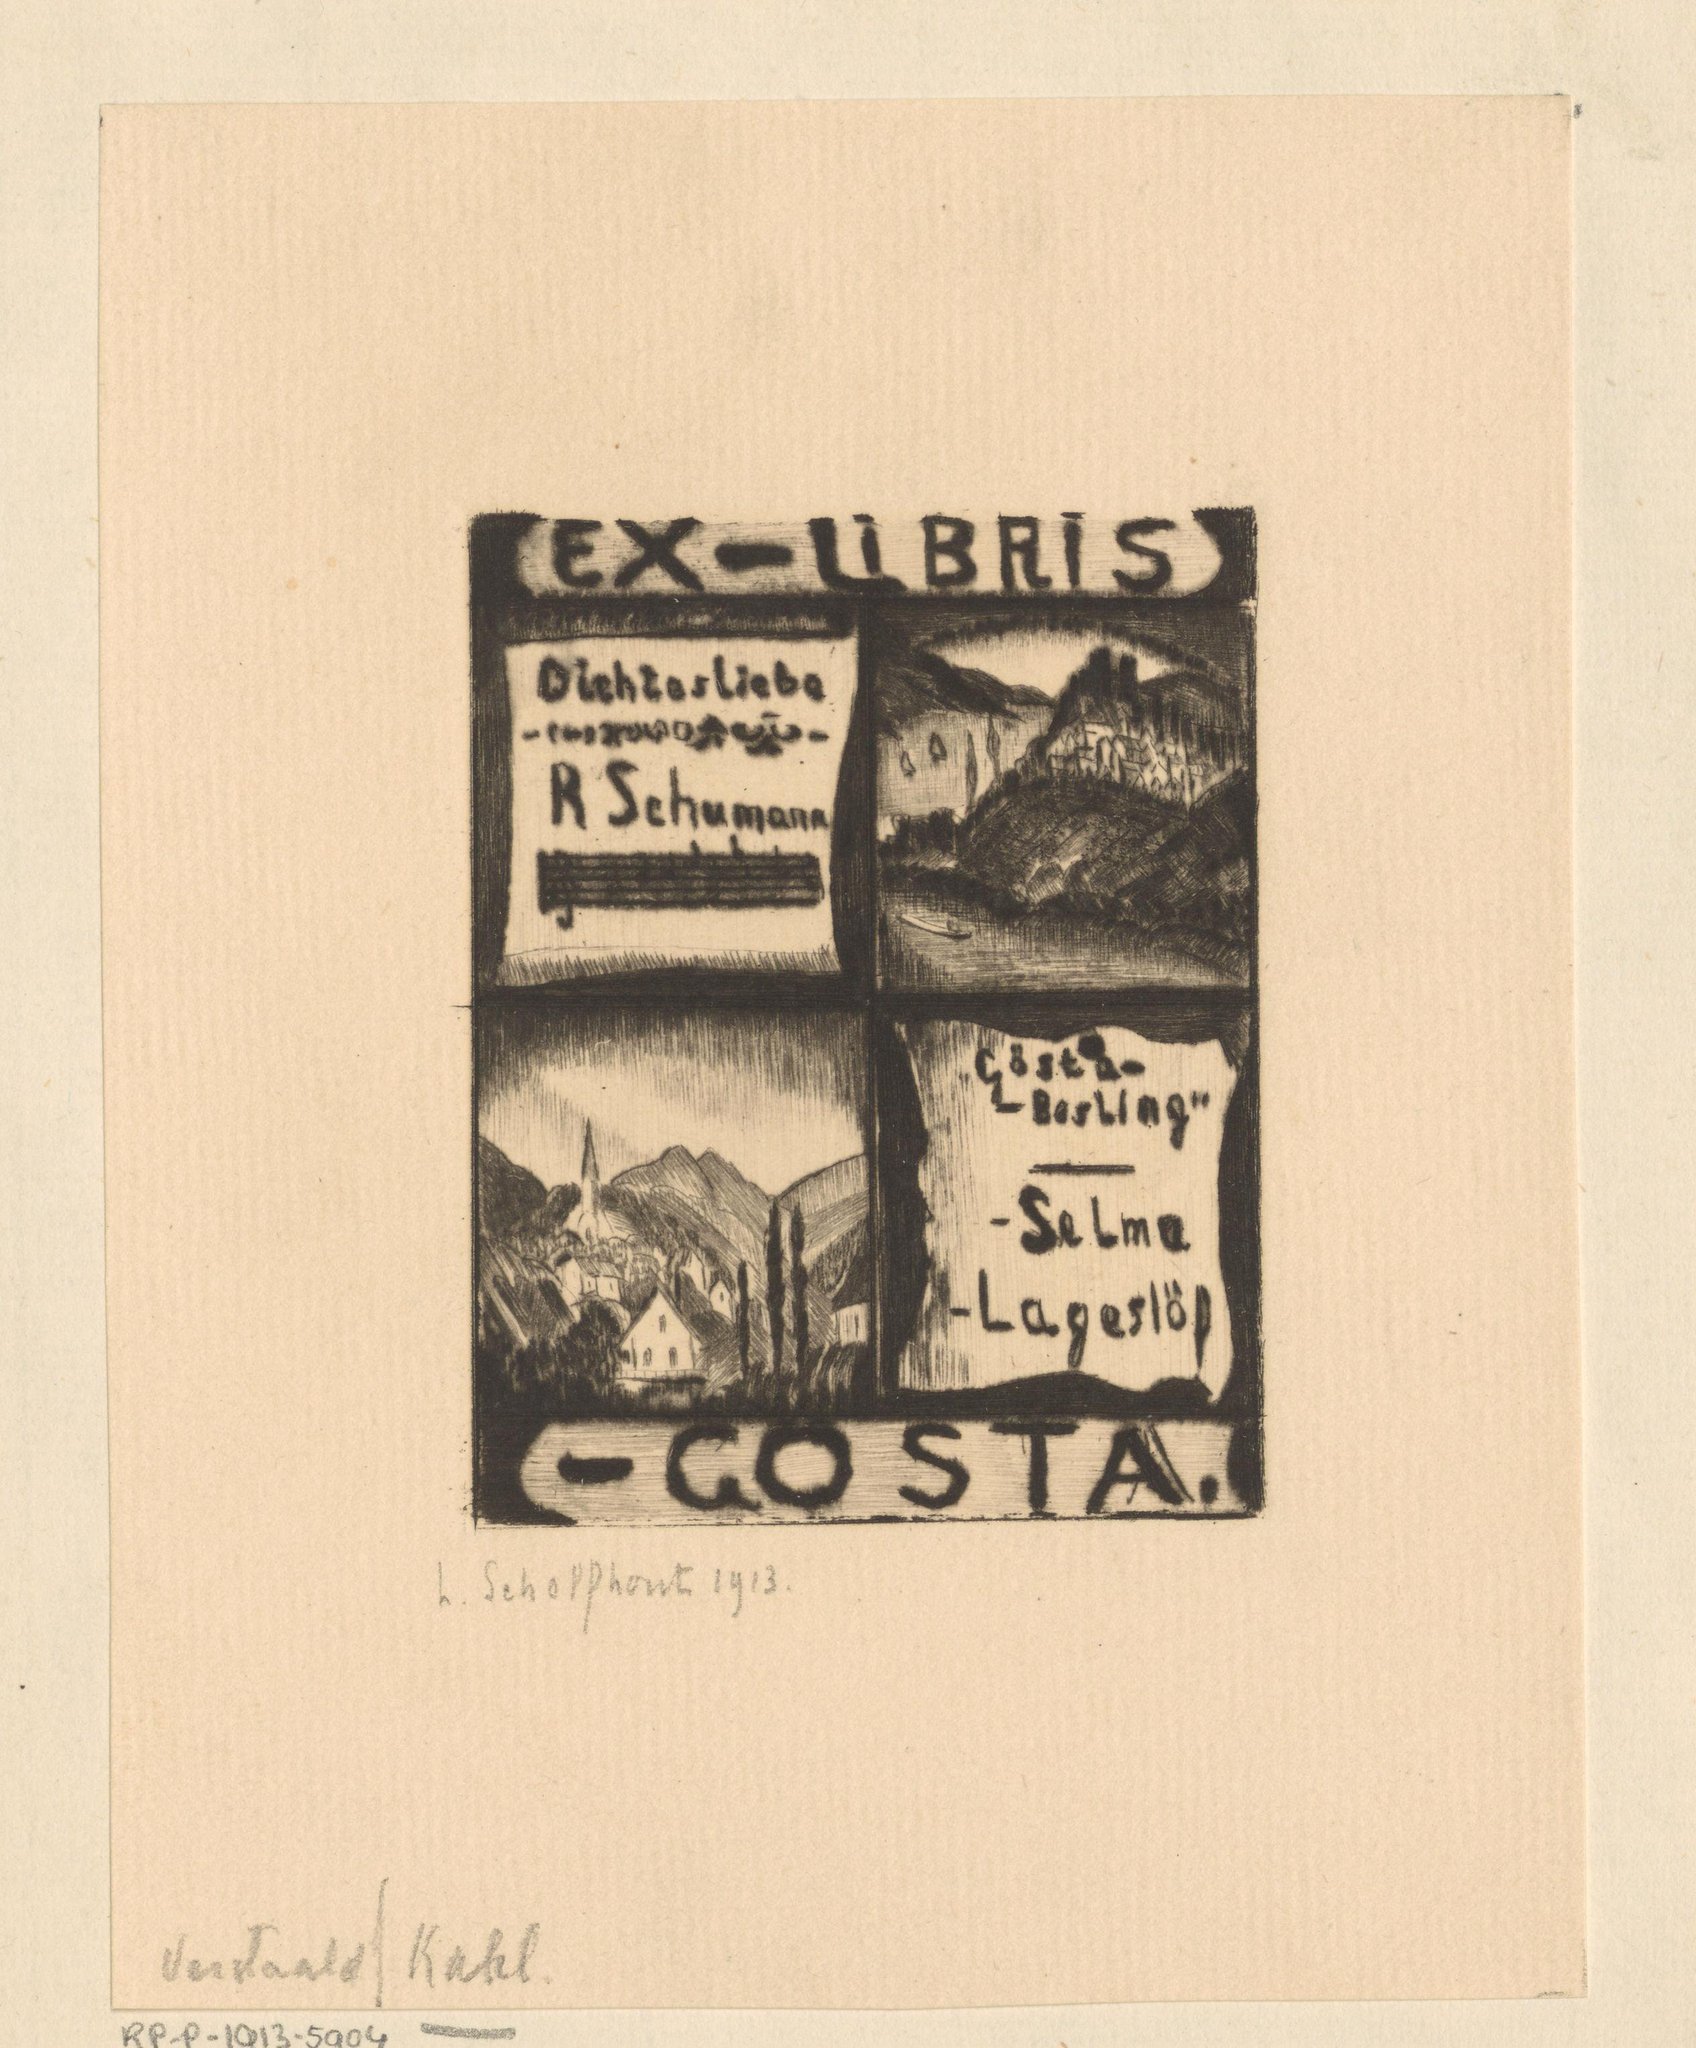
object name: bookplate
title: Ex libris van Alexis Kahl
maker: lodewijk schelfhout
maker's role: draughtsman, print maker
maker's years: 1881-1943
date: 1913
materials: paper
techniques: etching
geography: schlangenbad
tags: zwickau, robert schumann, dale, valley, mountains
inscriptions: signature and date: ‘L. Schelfhout 1913’, collector's mark: Lugt 2233